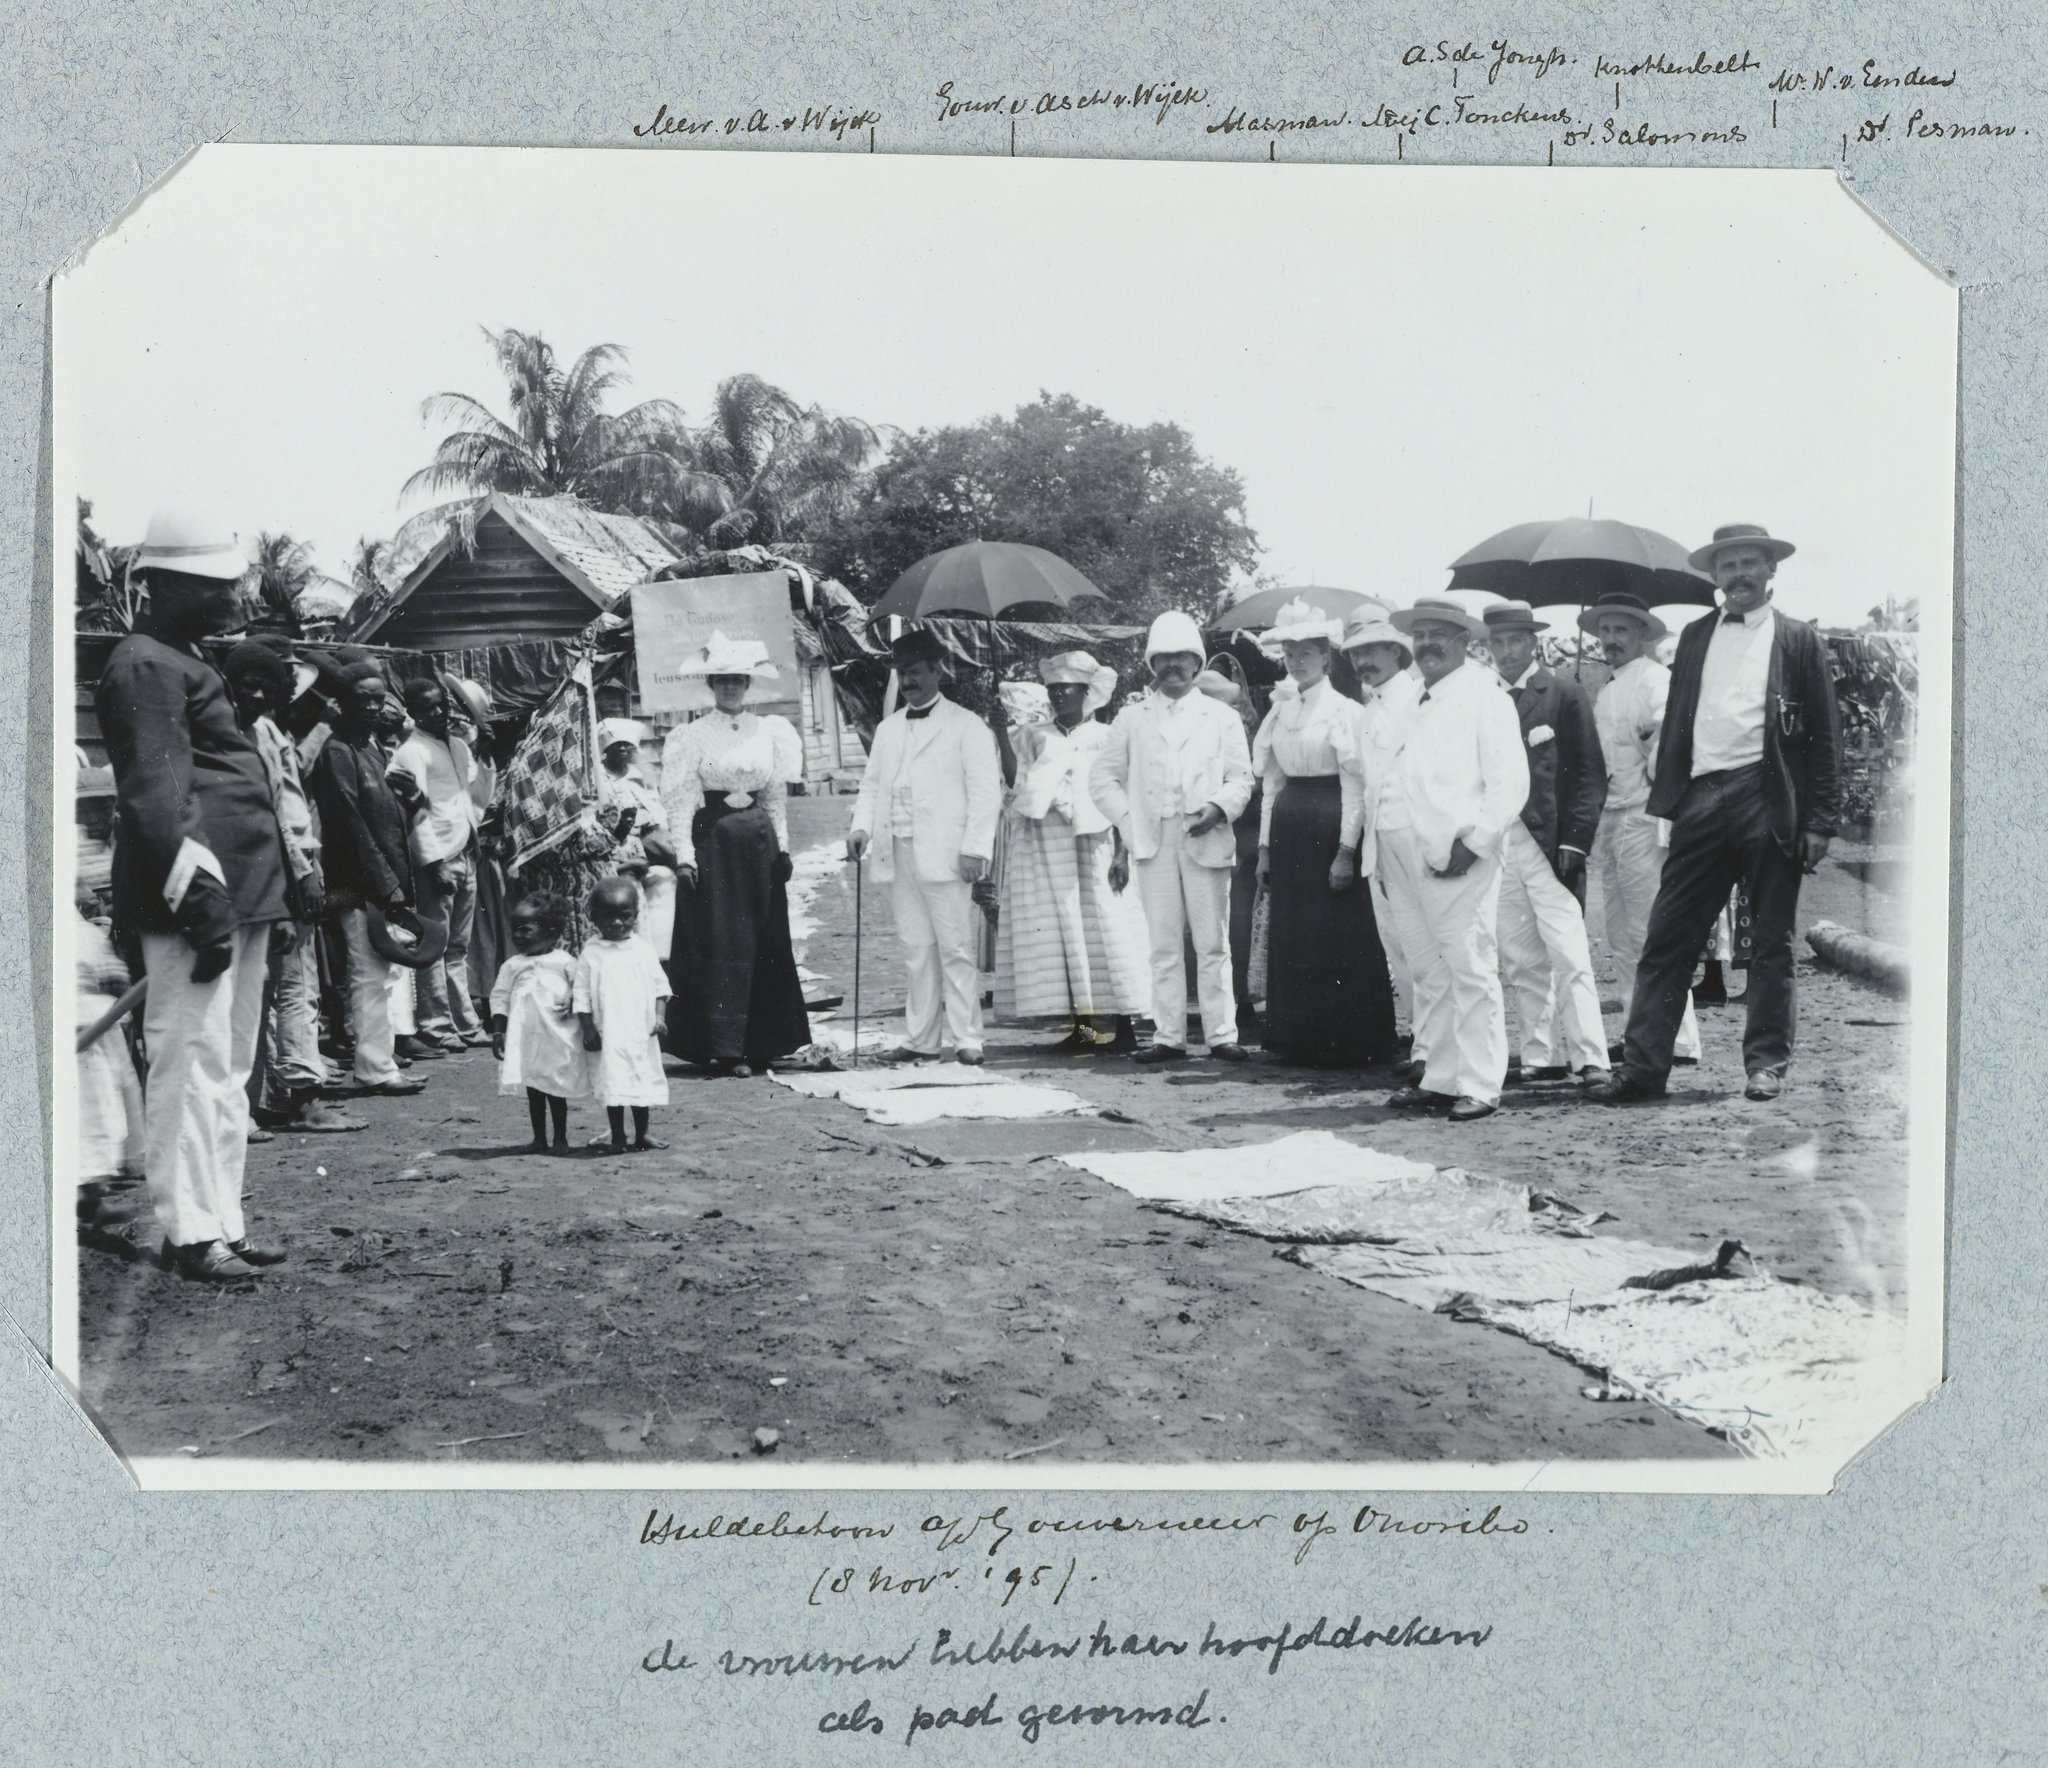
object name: photograph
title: Huldebetoon a/d Gouverneur op Onoribo (8 nov. '95)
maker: théodore van lelyveld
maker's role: painter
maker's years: 1867-1954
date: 1895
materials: photographic support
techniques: gelatin silver print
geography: suriname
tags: utrecht, the hague, public road in village (+ city(-scape) with figures, staffage)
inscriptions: inscription: ‘Dorp Onoribo’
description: Feestelijk onthaal op 8 november 1895 van gouverneur Titus van Asch van Wijck met zijn vrouw en een gevolg in het dorp Onoribo. Vrouwen uit het dorp hebben met hun hoofddoeken een pad op de grond gelegd. Fotoafdruk in een fotoalbum van Théodore van Lelyveld over Suriname uit 1895-1898.